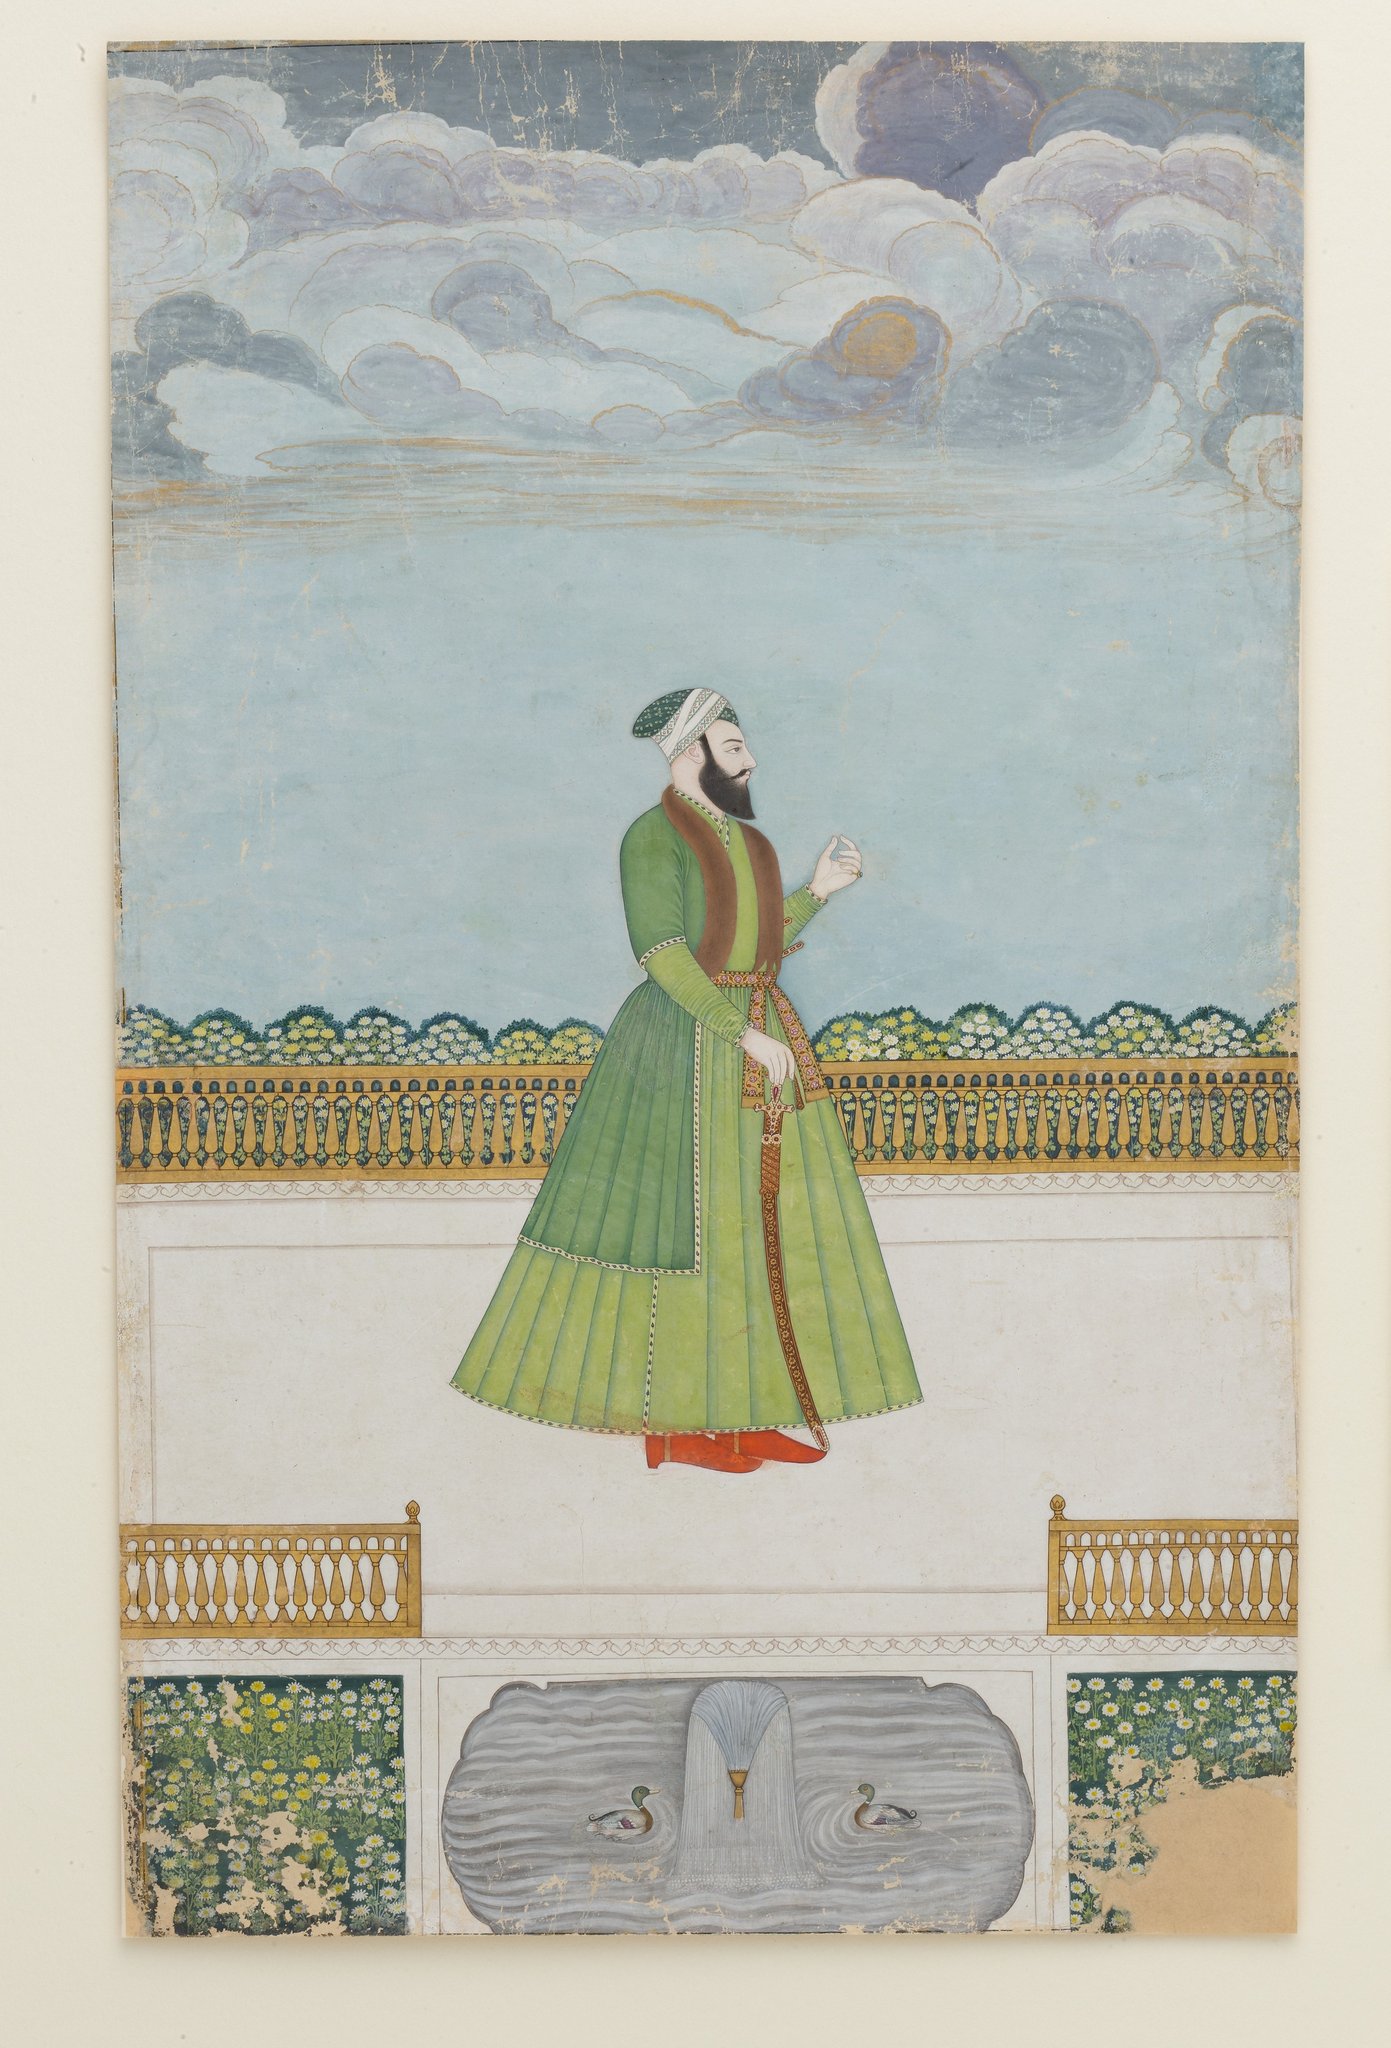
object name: illustrated single work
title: Nobleman on a Terrace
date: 1780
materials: gold, ink, paper, silver, watercolor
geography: india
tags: men,profiles